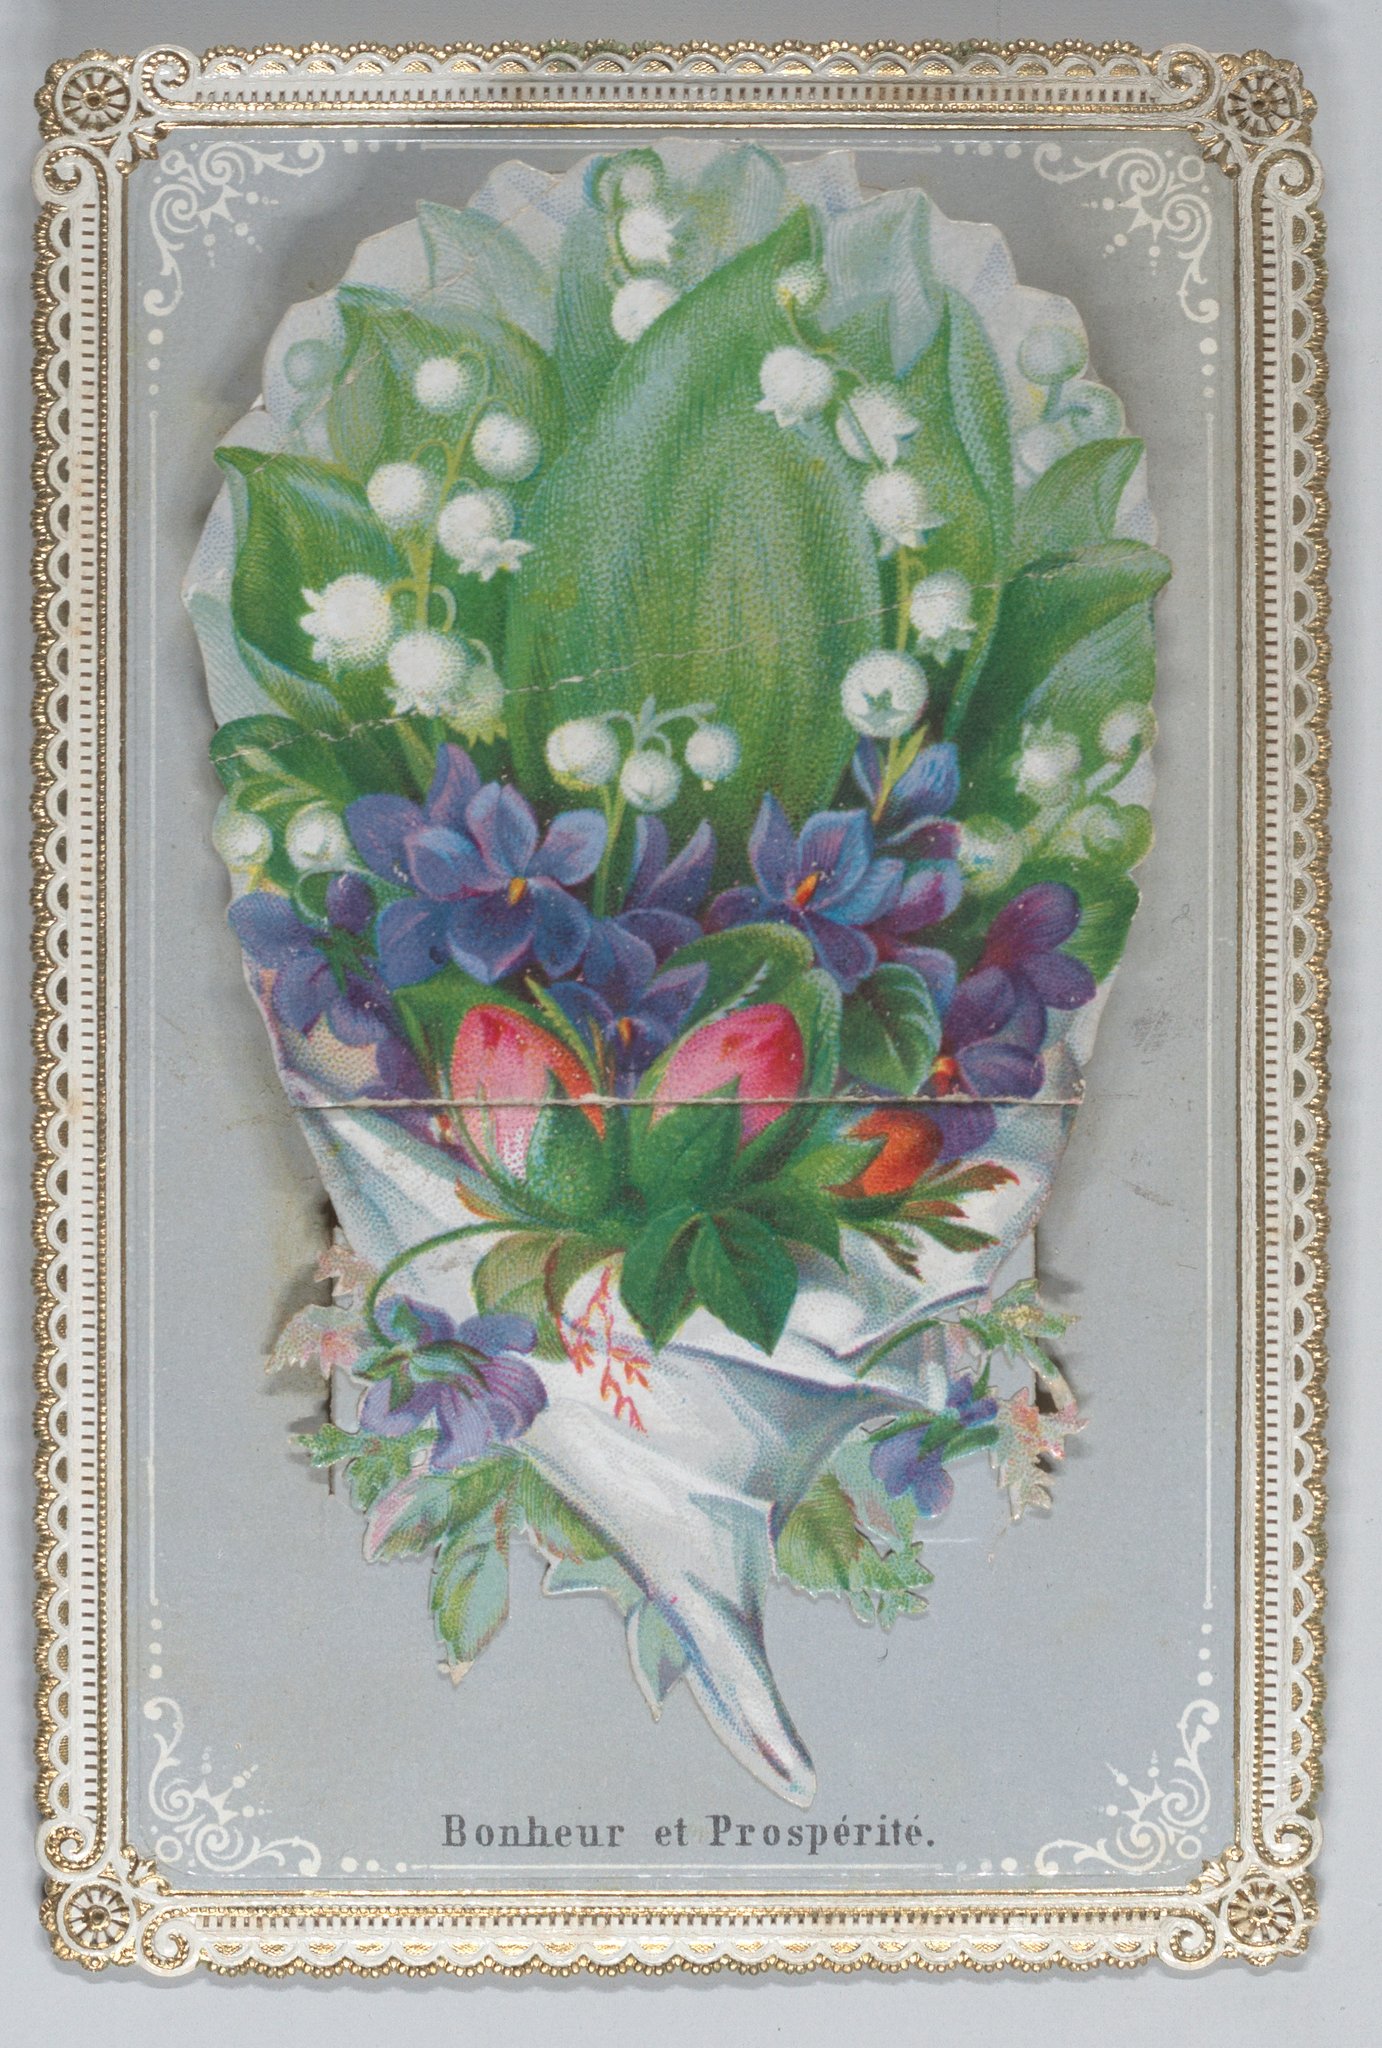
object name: valentine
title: Valentine - Mechanical bouquet, baby boy bunting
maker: anonymous, british, 19th century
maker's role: artist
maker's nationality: british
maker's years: 1800-1900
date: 1875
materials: ink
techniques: chromolithography, cutting, gilding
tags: infants,flowers